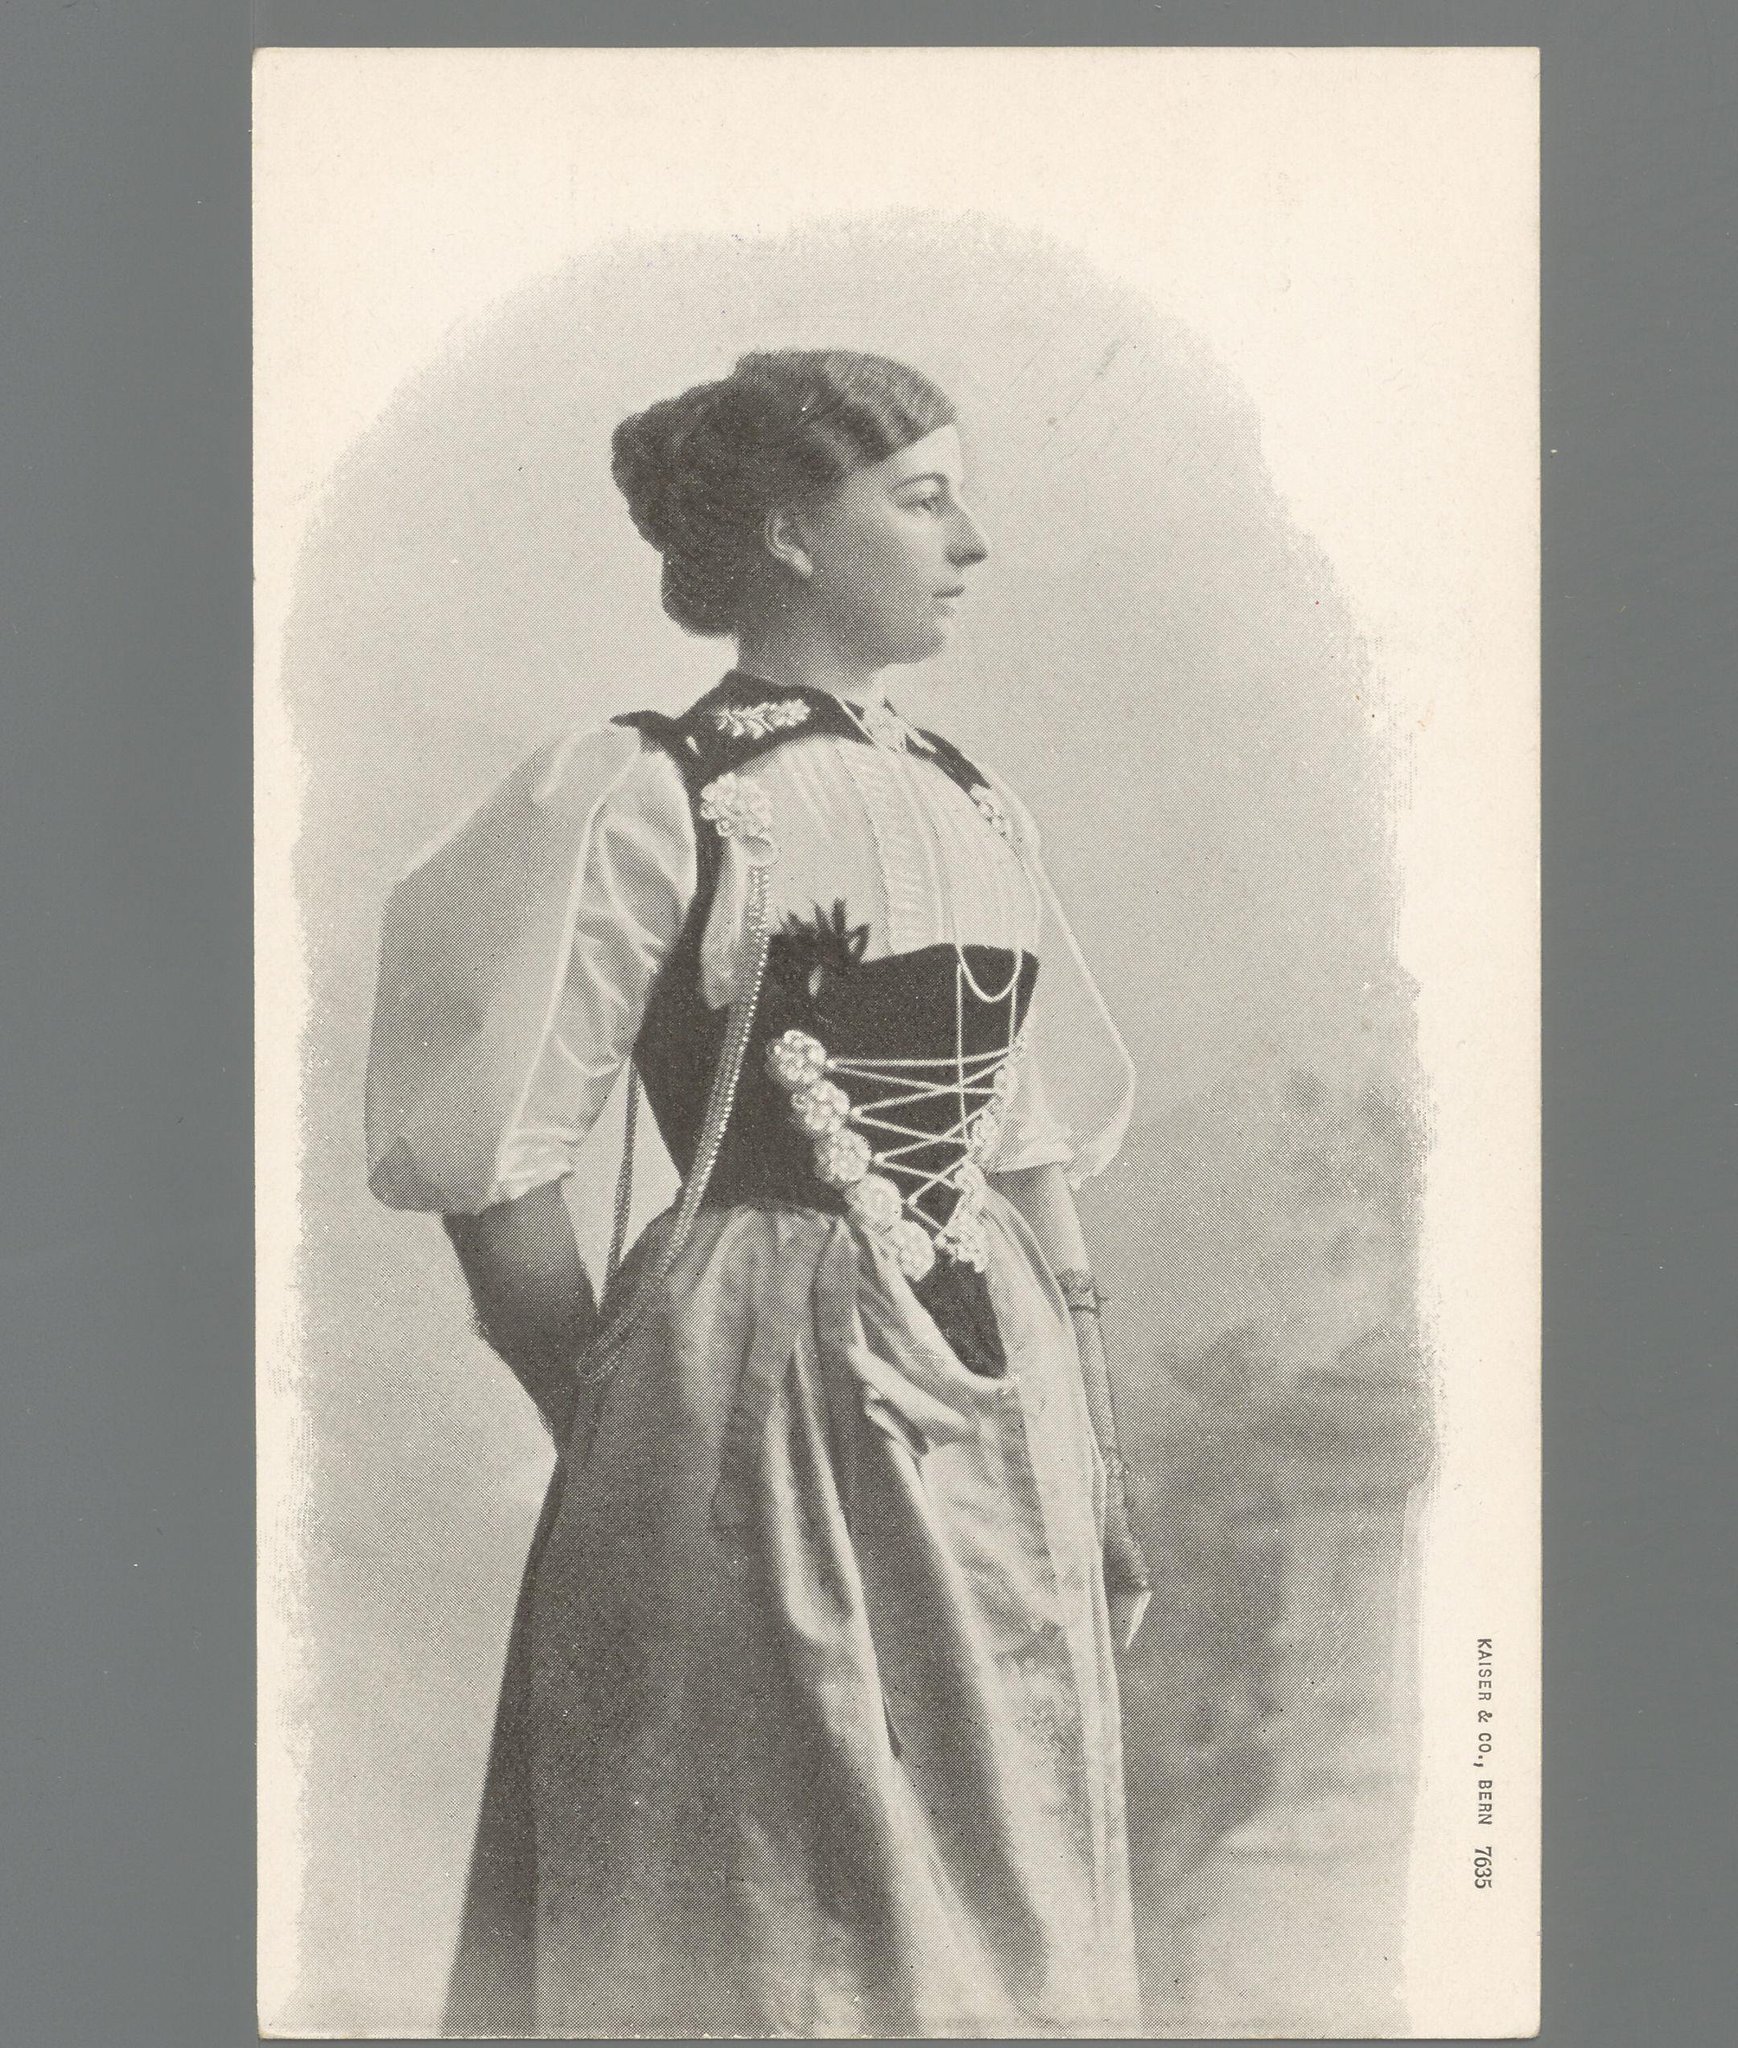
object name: ansichtkaart, prentbriefkaart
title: Vrouw in regionaal kostuum uit Zwitserland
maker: Anonymous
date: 1903-1904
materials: cardboard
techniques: autotype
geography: bern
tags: adult woman (+ three-quarter view), folk costume, regional costume, switzerland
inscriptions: stamp: ‘Congrès International de l'enseignement du dessin. 3 aout 1904. Berne 1904’